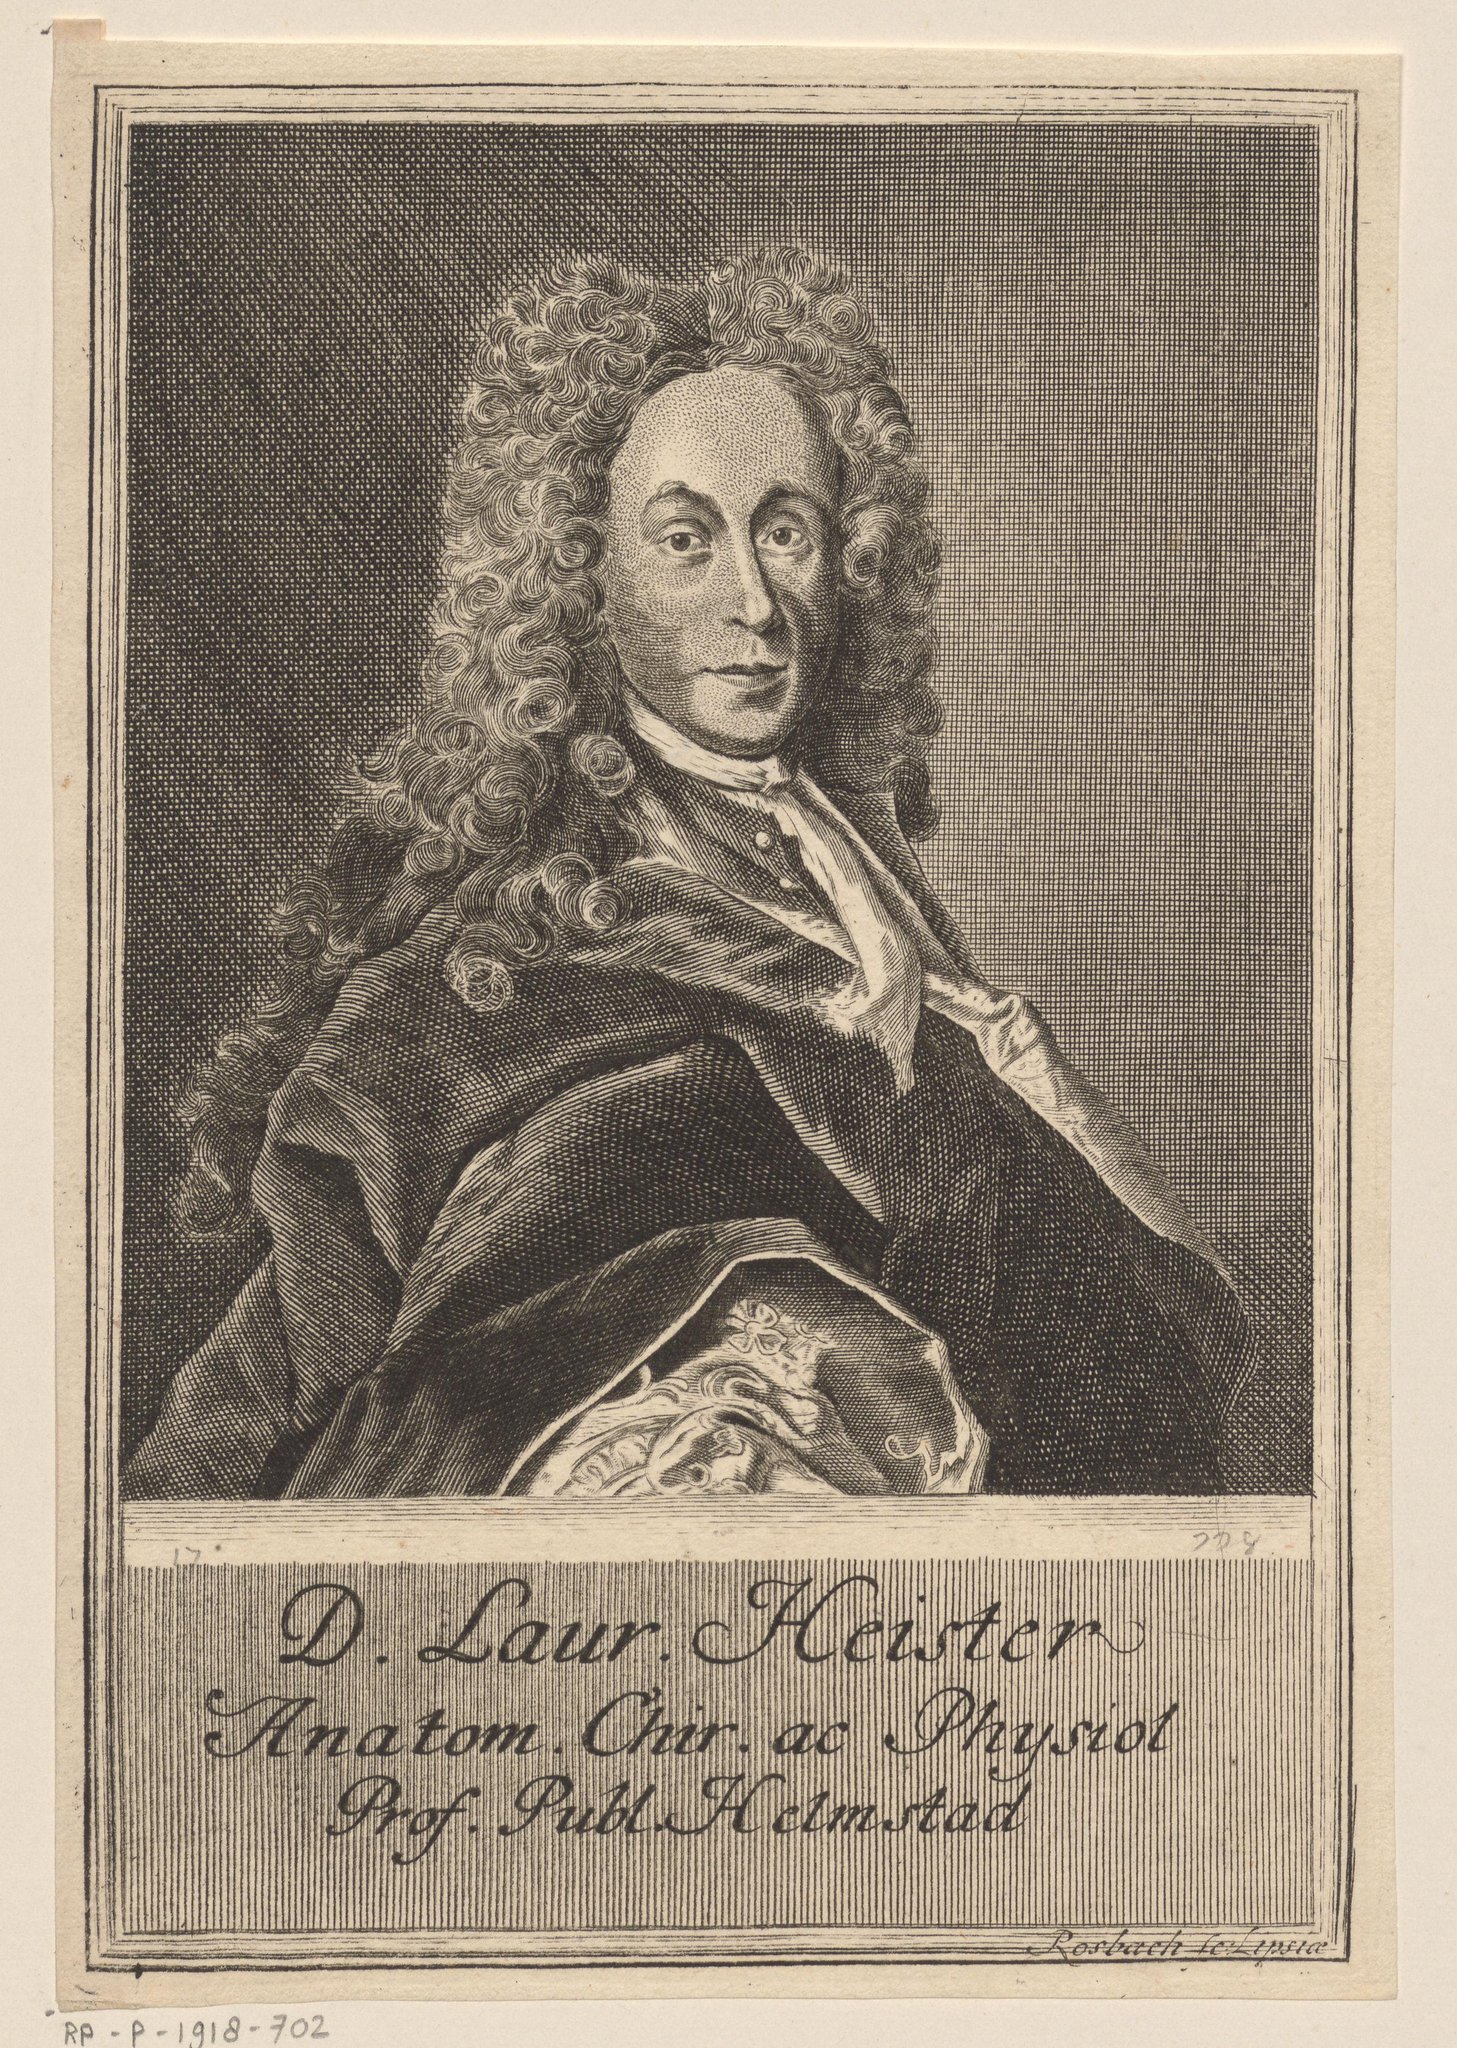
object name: print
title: Portret van Lorenz Heister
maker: johann friedrich rosbach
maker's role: print maker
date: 1725-1749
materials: paper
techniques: engraving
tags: historical persons, physician, doctor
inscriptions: collector's mark: Lugt 2233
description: Prent gebruikt in: Heister, Lorenz. Chirurgie, in welcher alles, was zur Wund-Artney gehöret, (...). Neurenberg: erven Johann Hoffmann, 1731.